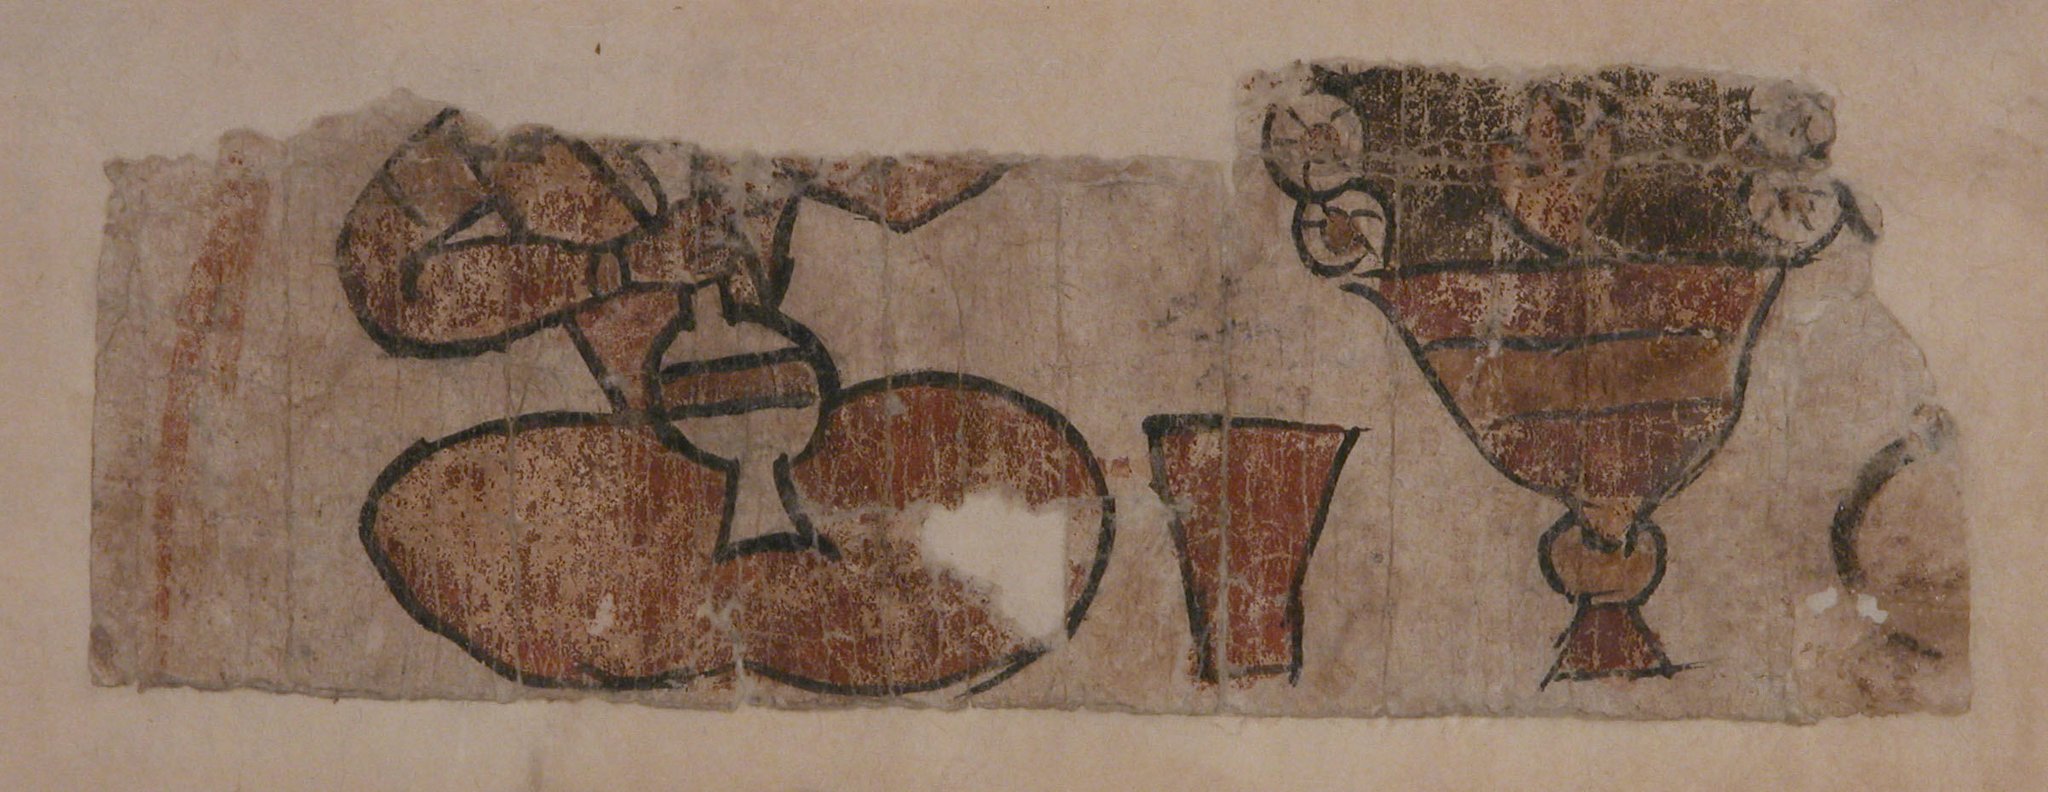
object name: folio from an illustrated manuscript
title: Seated Figure with Crossed Legs Holding a Carafe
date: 1301-1400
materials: ink, paper, watercolor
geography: egypt or syria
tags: human figures